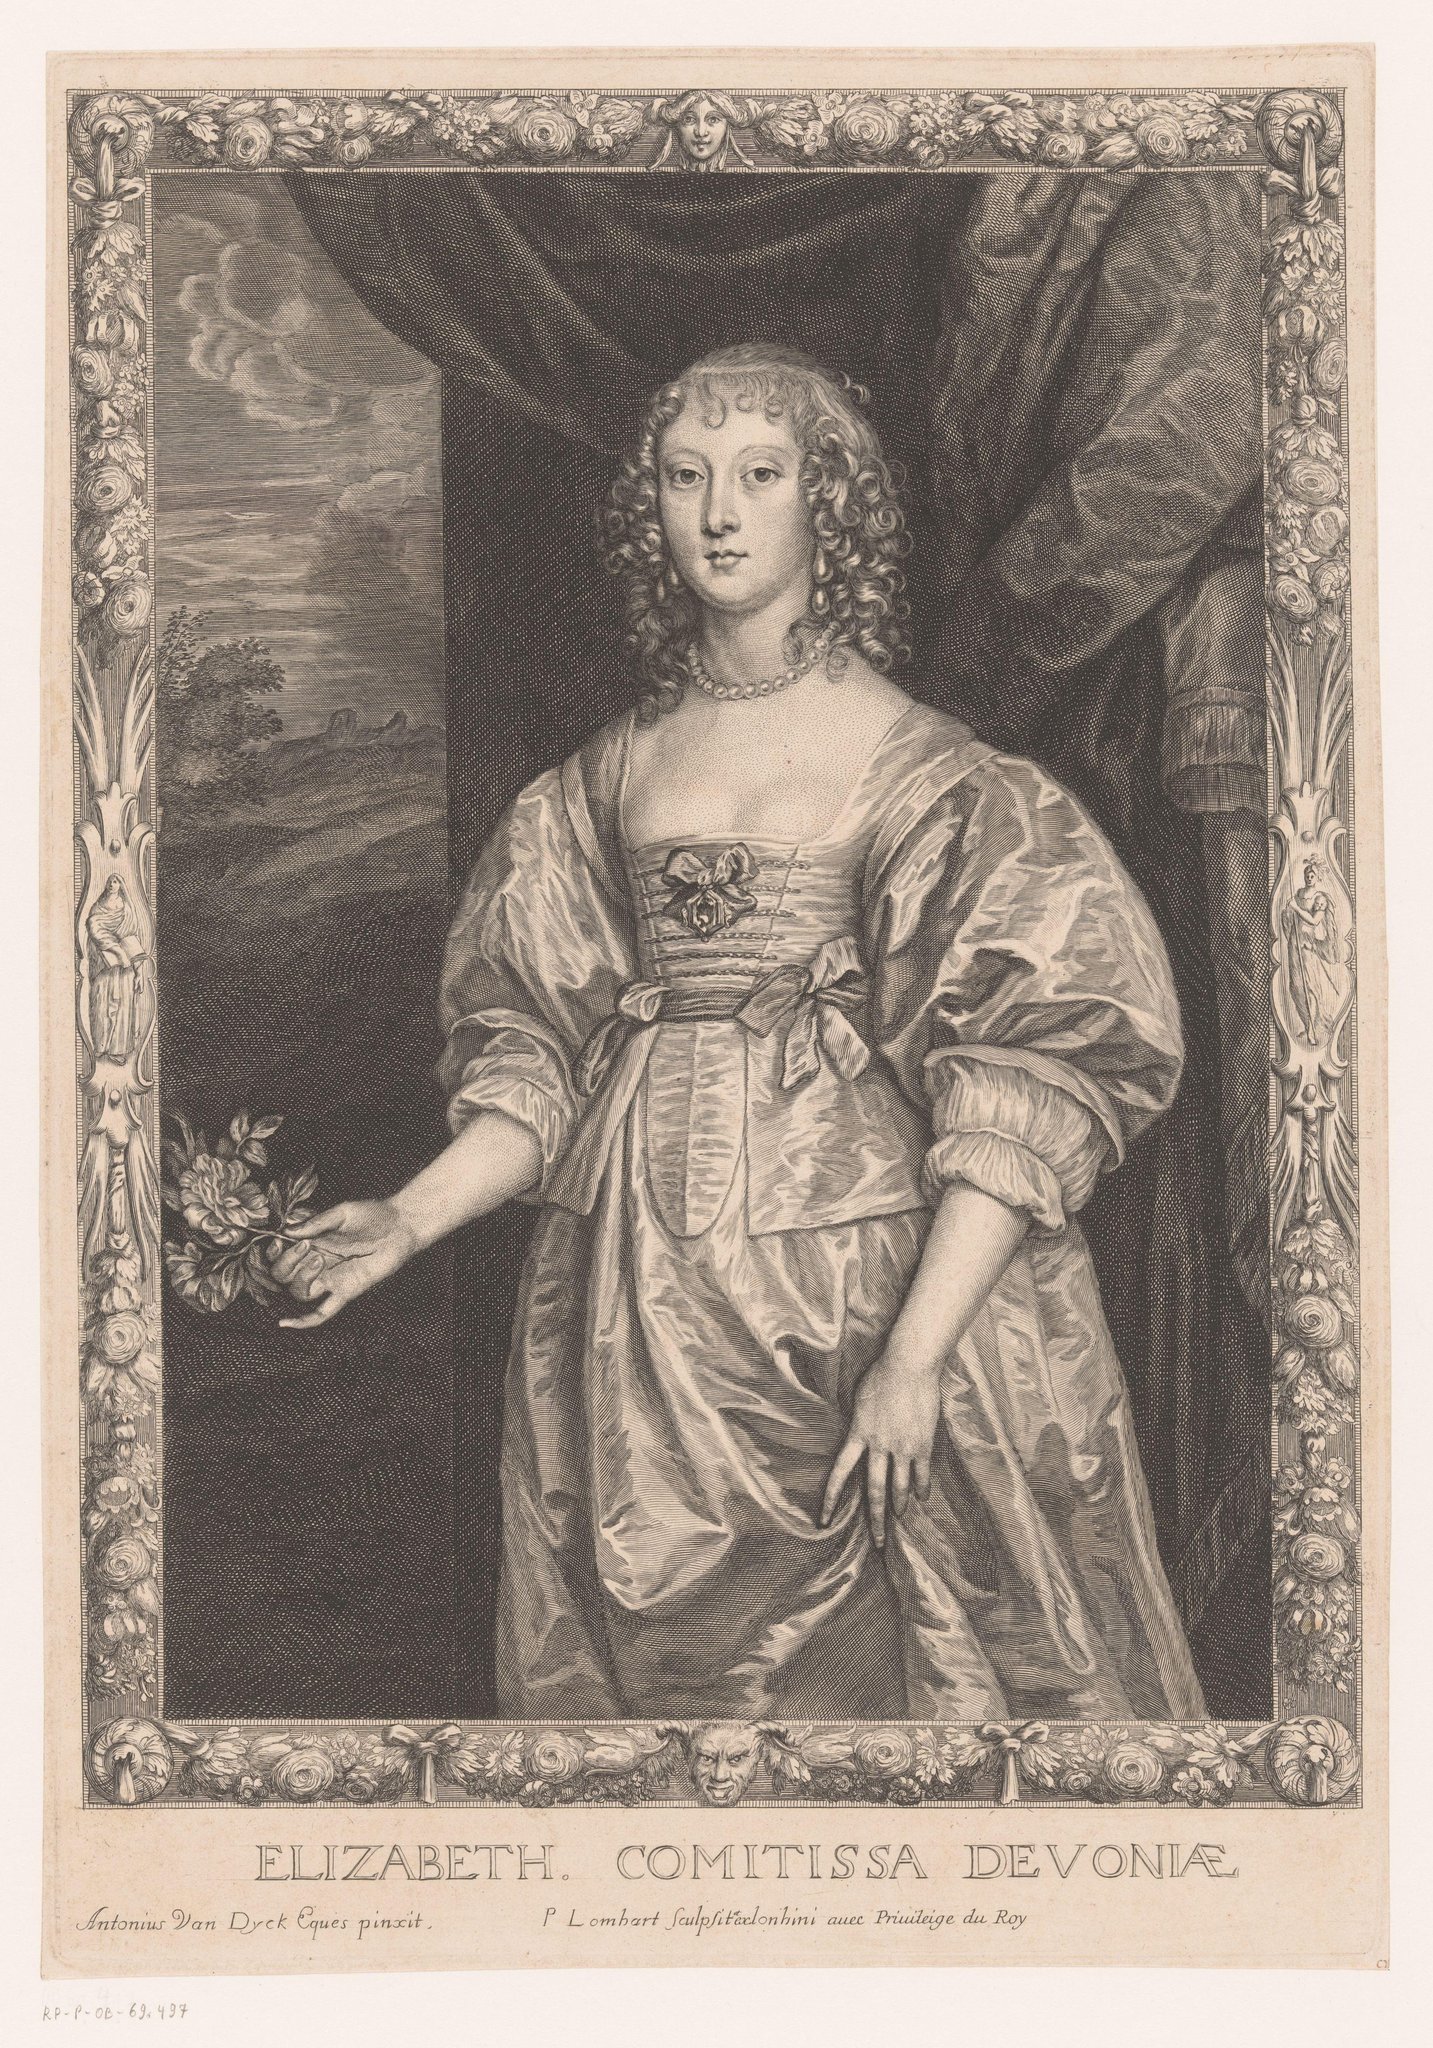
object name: print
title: Portretten van graven en gravinnen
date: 1660-1663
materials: paper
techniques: engraving, etching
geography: london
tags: elizabeth cavendish (hertogin van devonshire), historical persons - bb - woman, frame of painting, etc., nobility and patriciate; chivalry, knighthood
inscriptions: collector's mark: Lugt 240